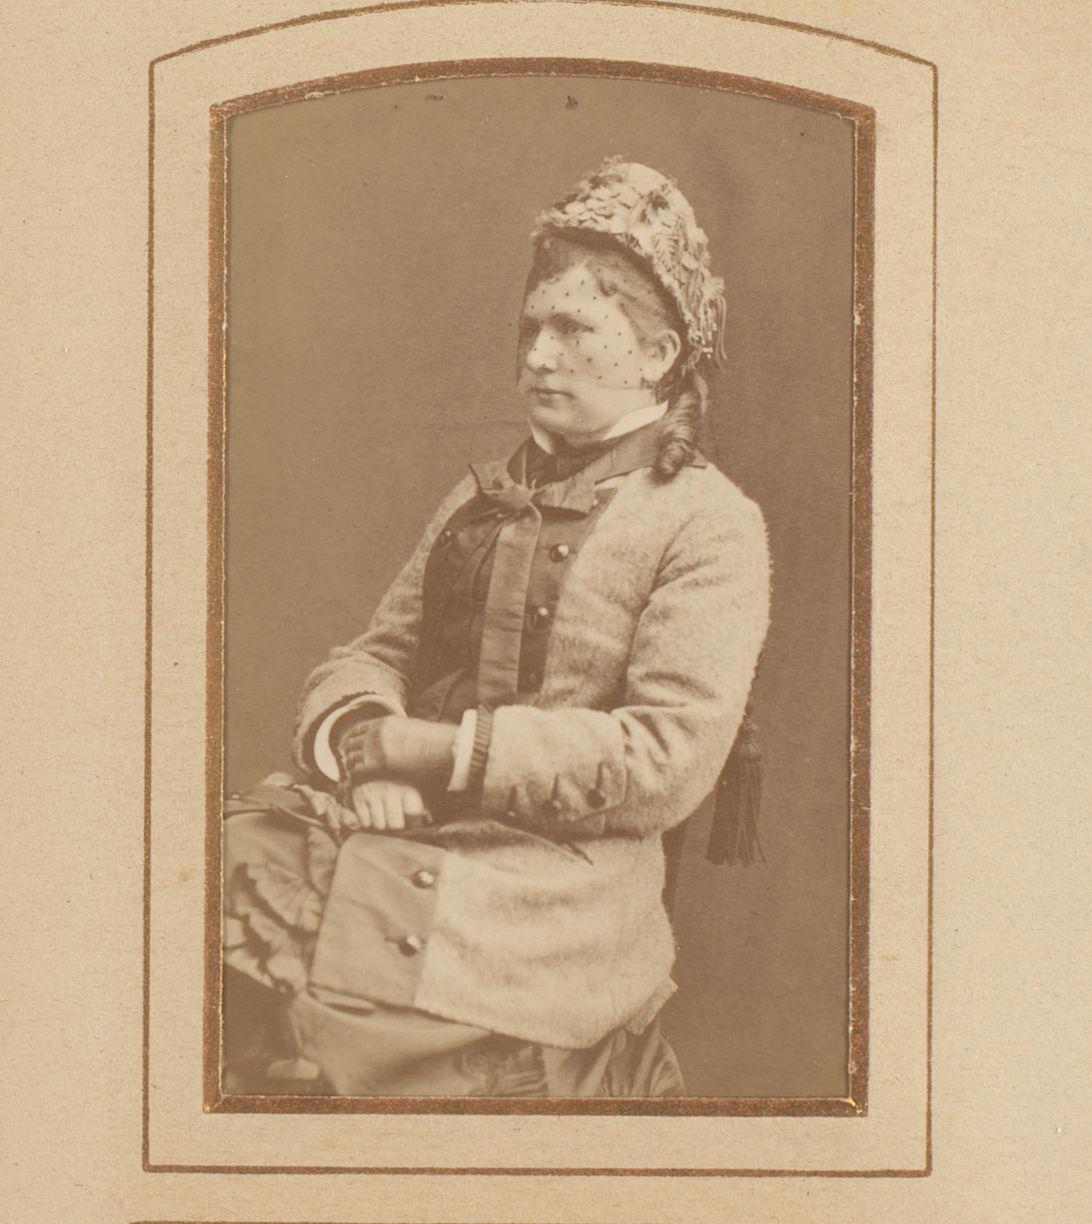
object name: album leaf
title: Portret van een zittende vrouw met muts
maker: Anonymous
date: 1870-1900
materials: cardboard, photographic support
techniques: albumen print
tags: historical persons - bb - woman, head-gear: cap